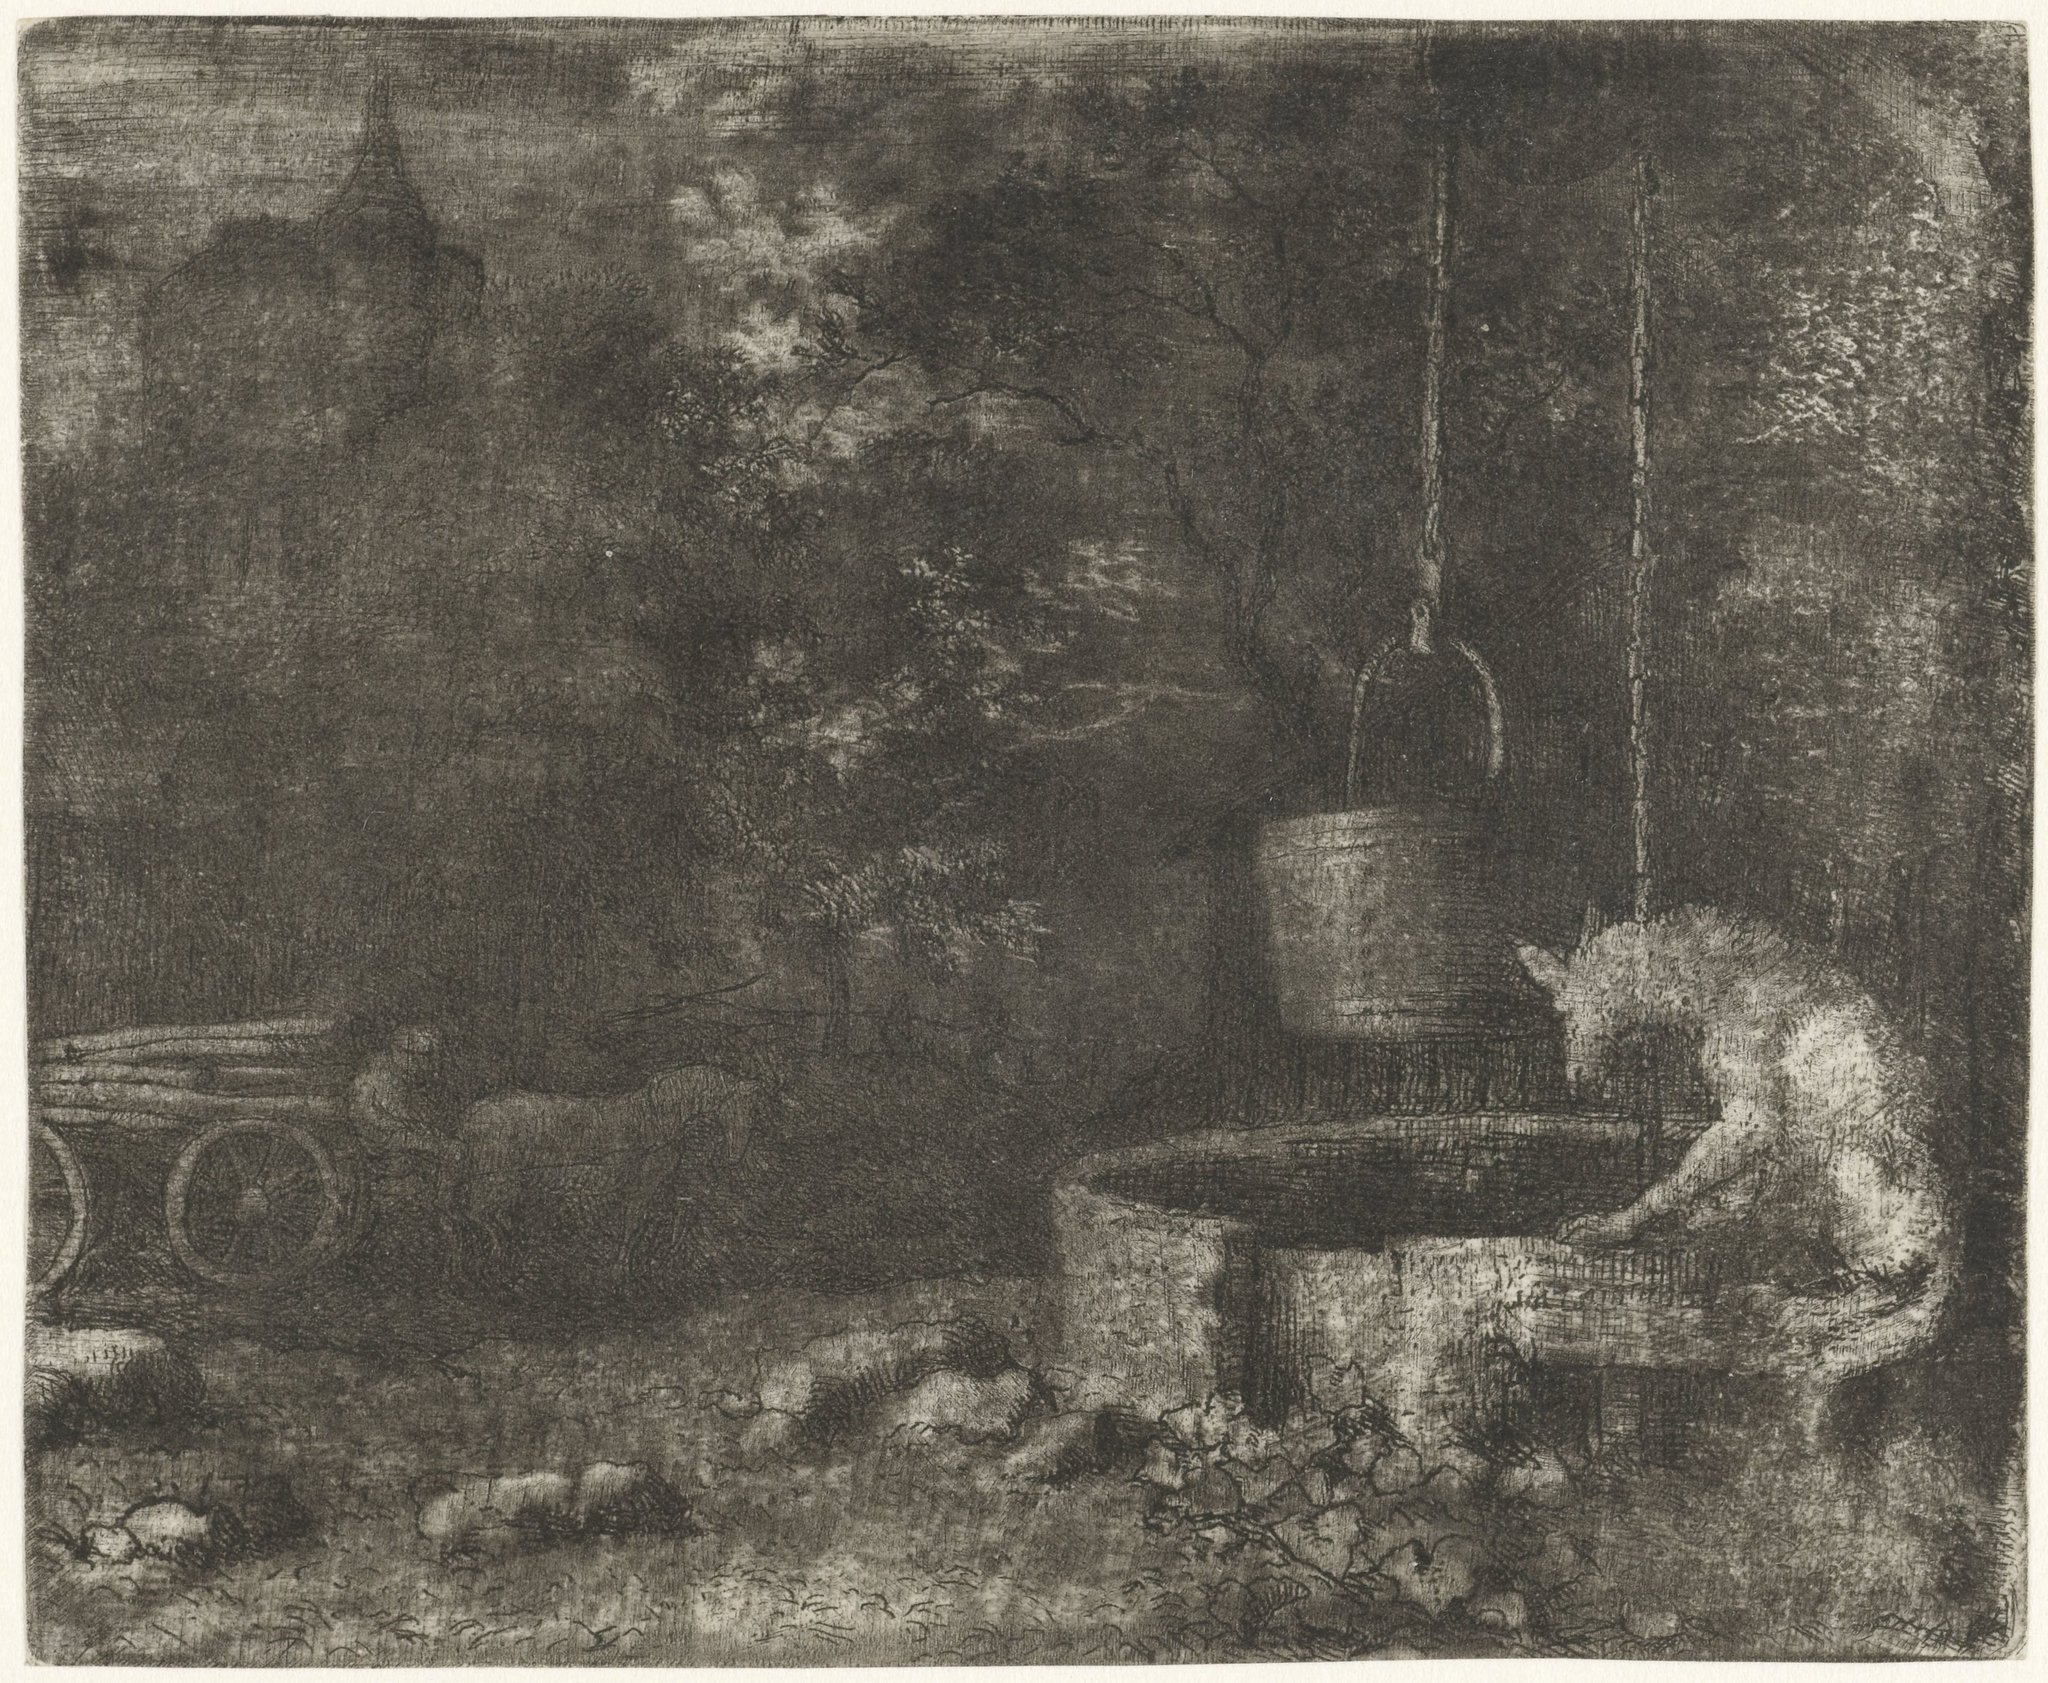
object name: print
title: Reinaert de vos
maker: allaert van everdingen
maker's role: draughtsman, painter, print maker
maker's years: 1621-1675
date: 1665-1675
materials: paper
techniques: etching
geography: netherlands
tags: fable of reynard the fox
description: Reinaert de vos kijkt in een waterput. Op de achtergrond een paard en wagen.